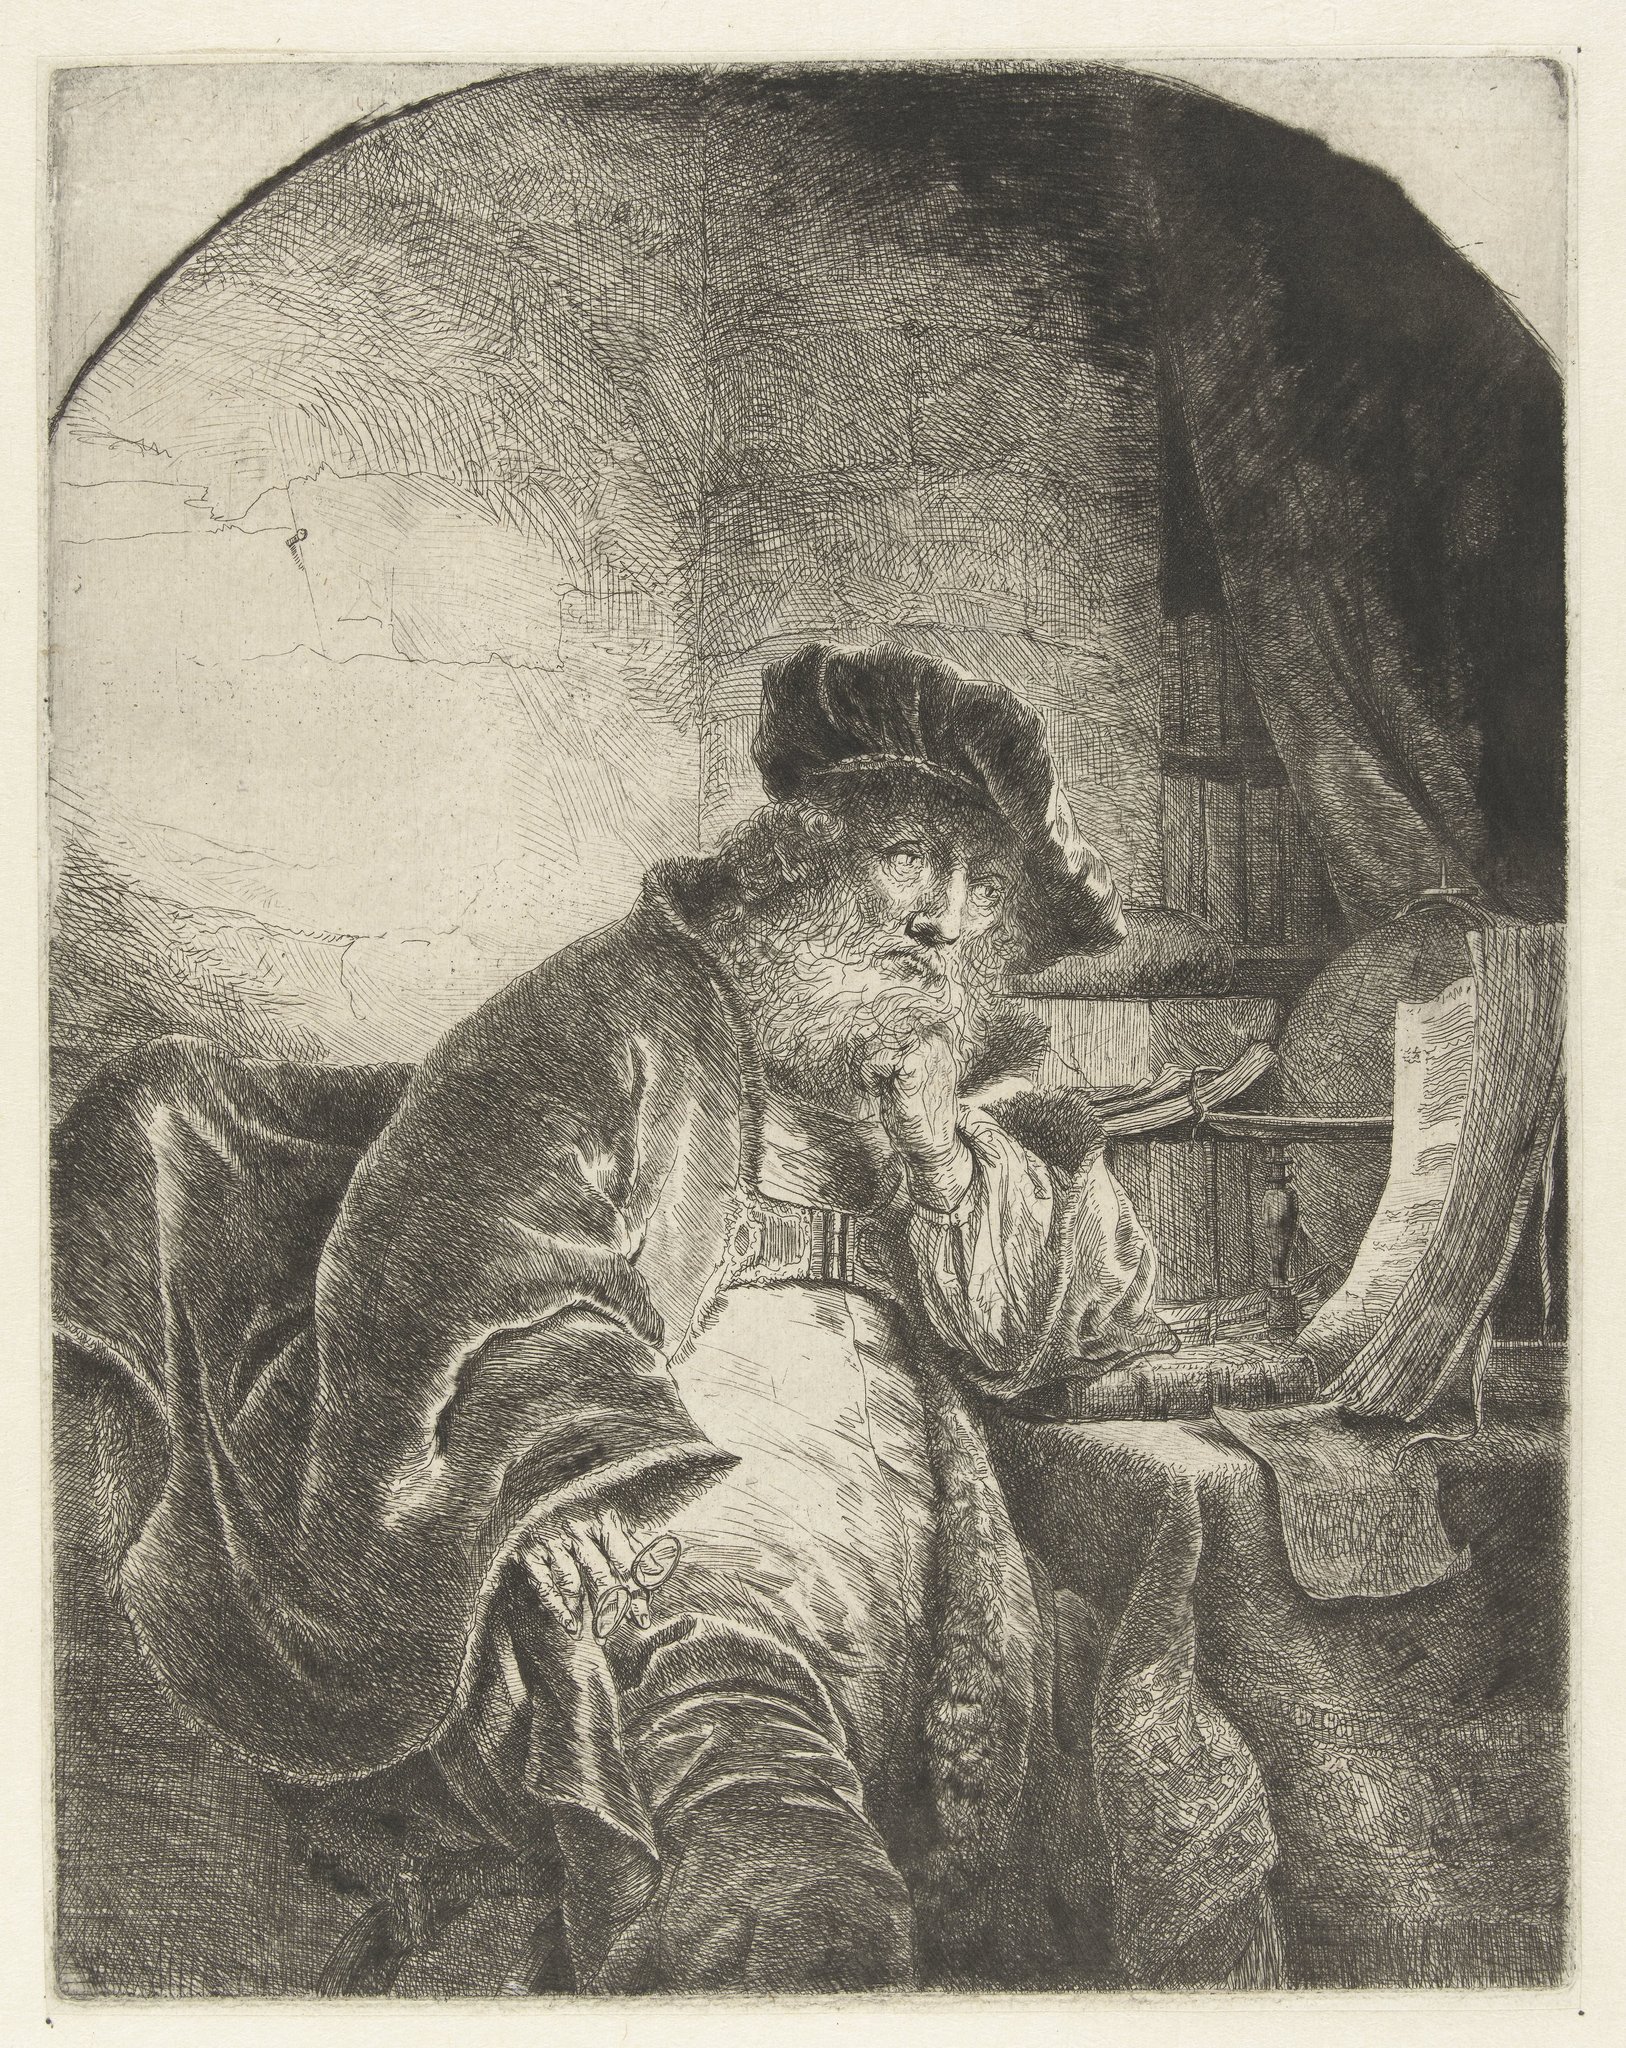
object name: print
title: Peinzende filosoof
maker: ferdinand bol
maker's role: draughtsman, painter, print maker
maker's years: 1616-1680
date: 1653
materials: paper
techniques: drypoint, etching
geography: amsterdam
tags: scholar, philosopher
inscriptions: collector's mark: Lugt 240